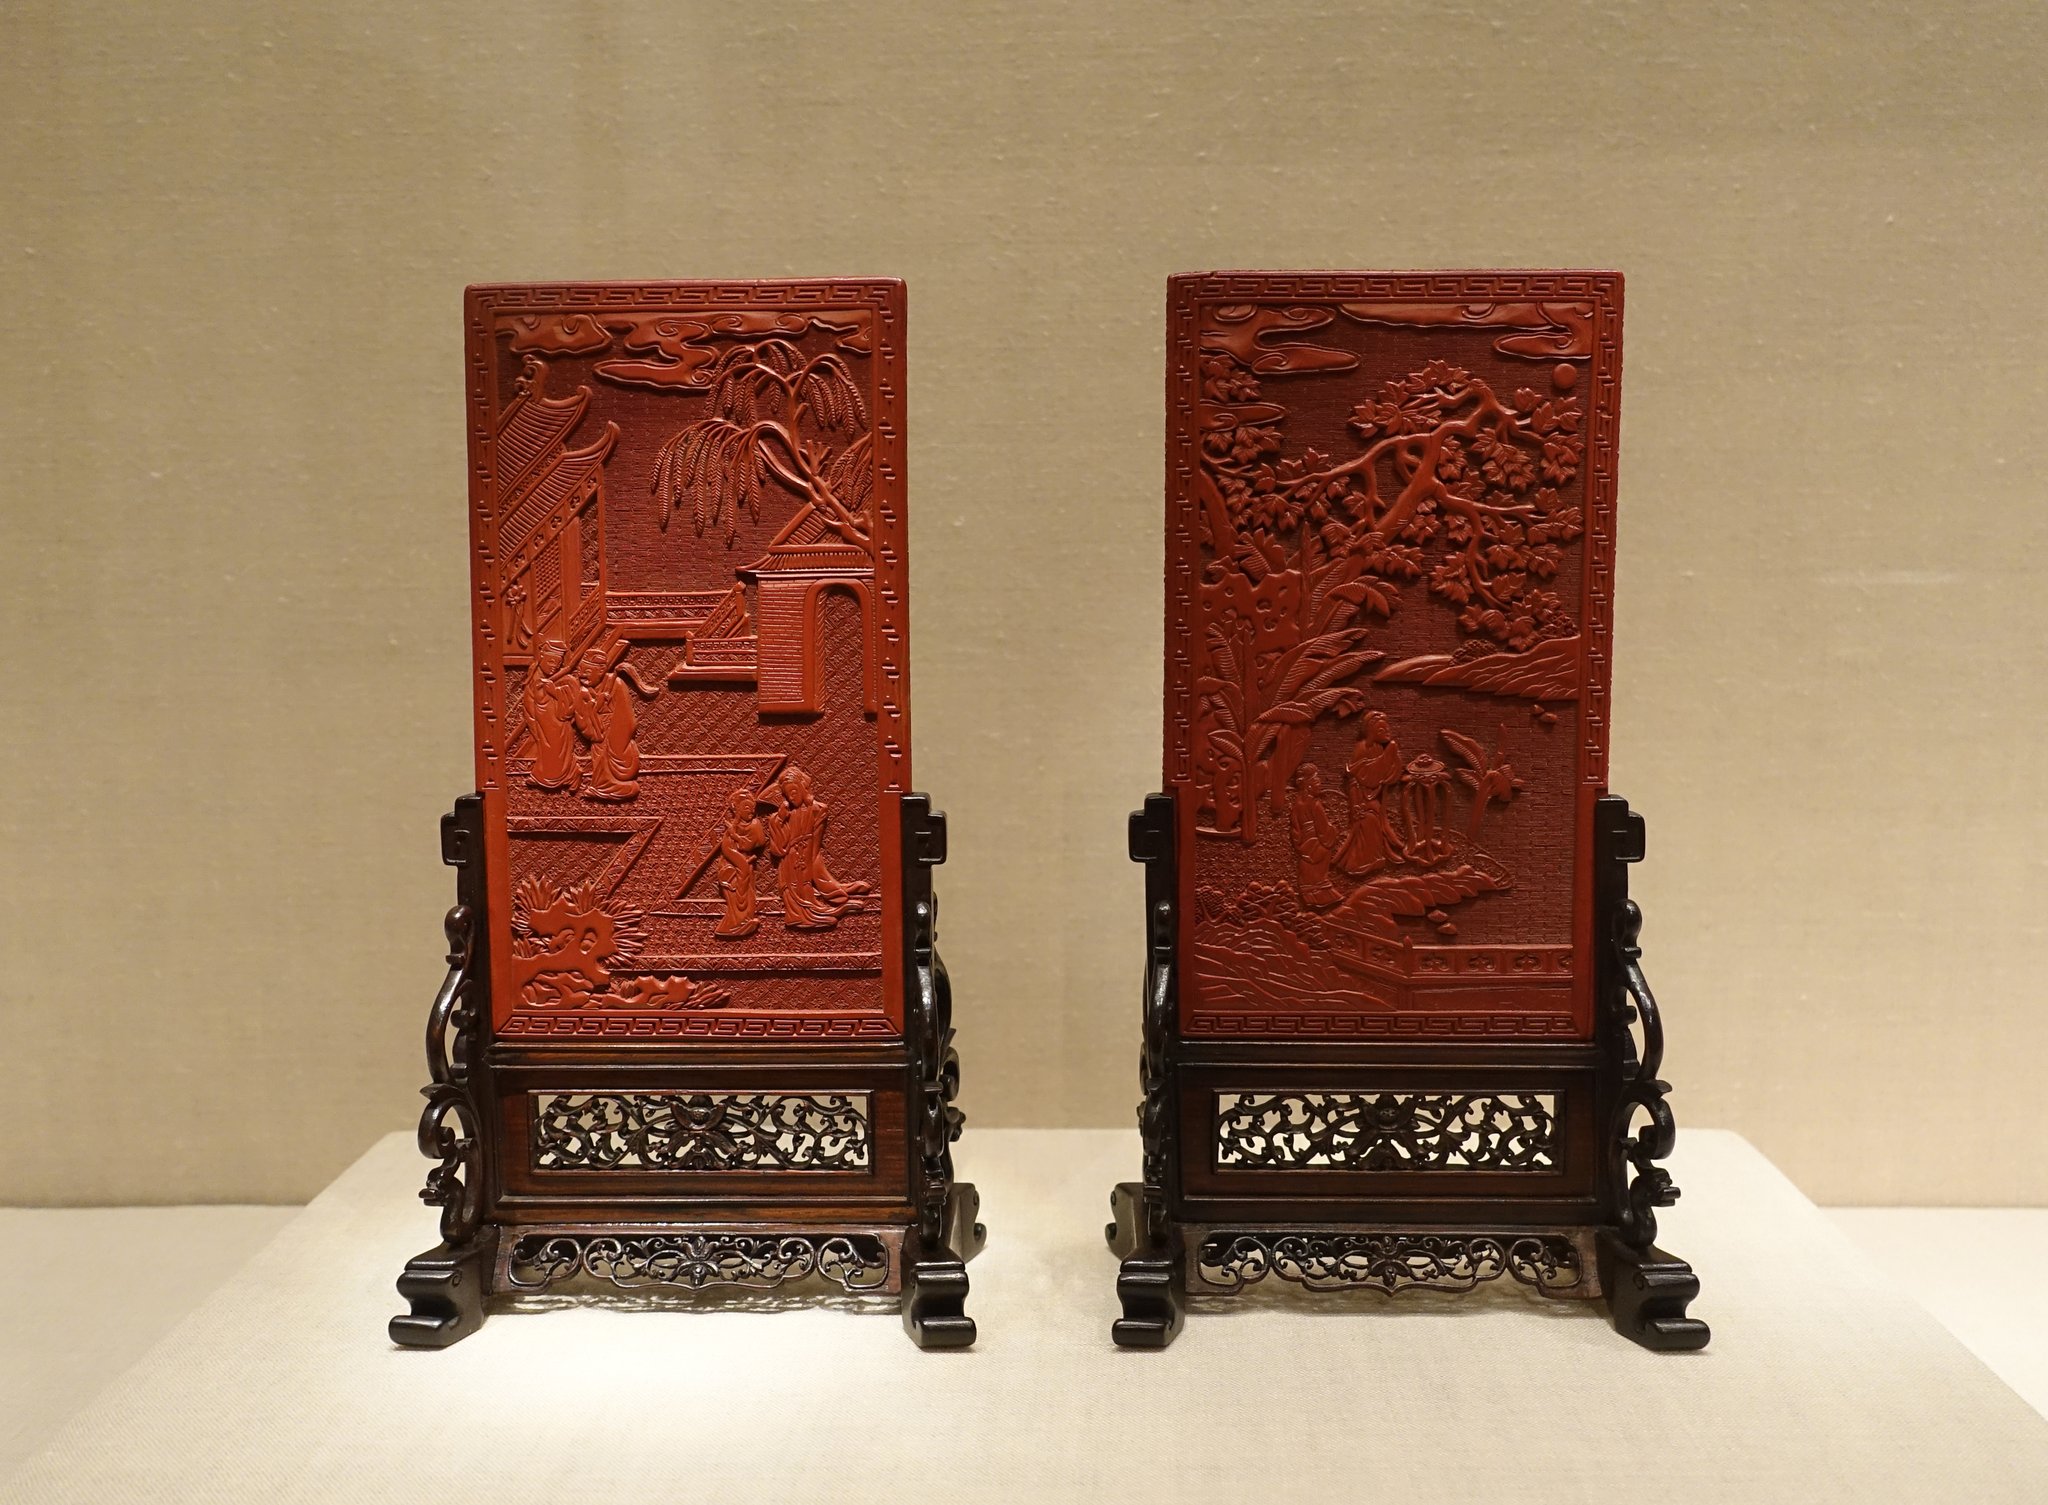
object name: screen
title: Pair of screens with scenes from Romance of the West Chamber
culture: chinese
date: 1701-1900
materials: lacquer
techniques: carving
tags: men,women,butterflies,landscapes